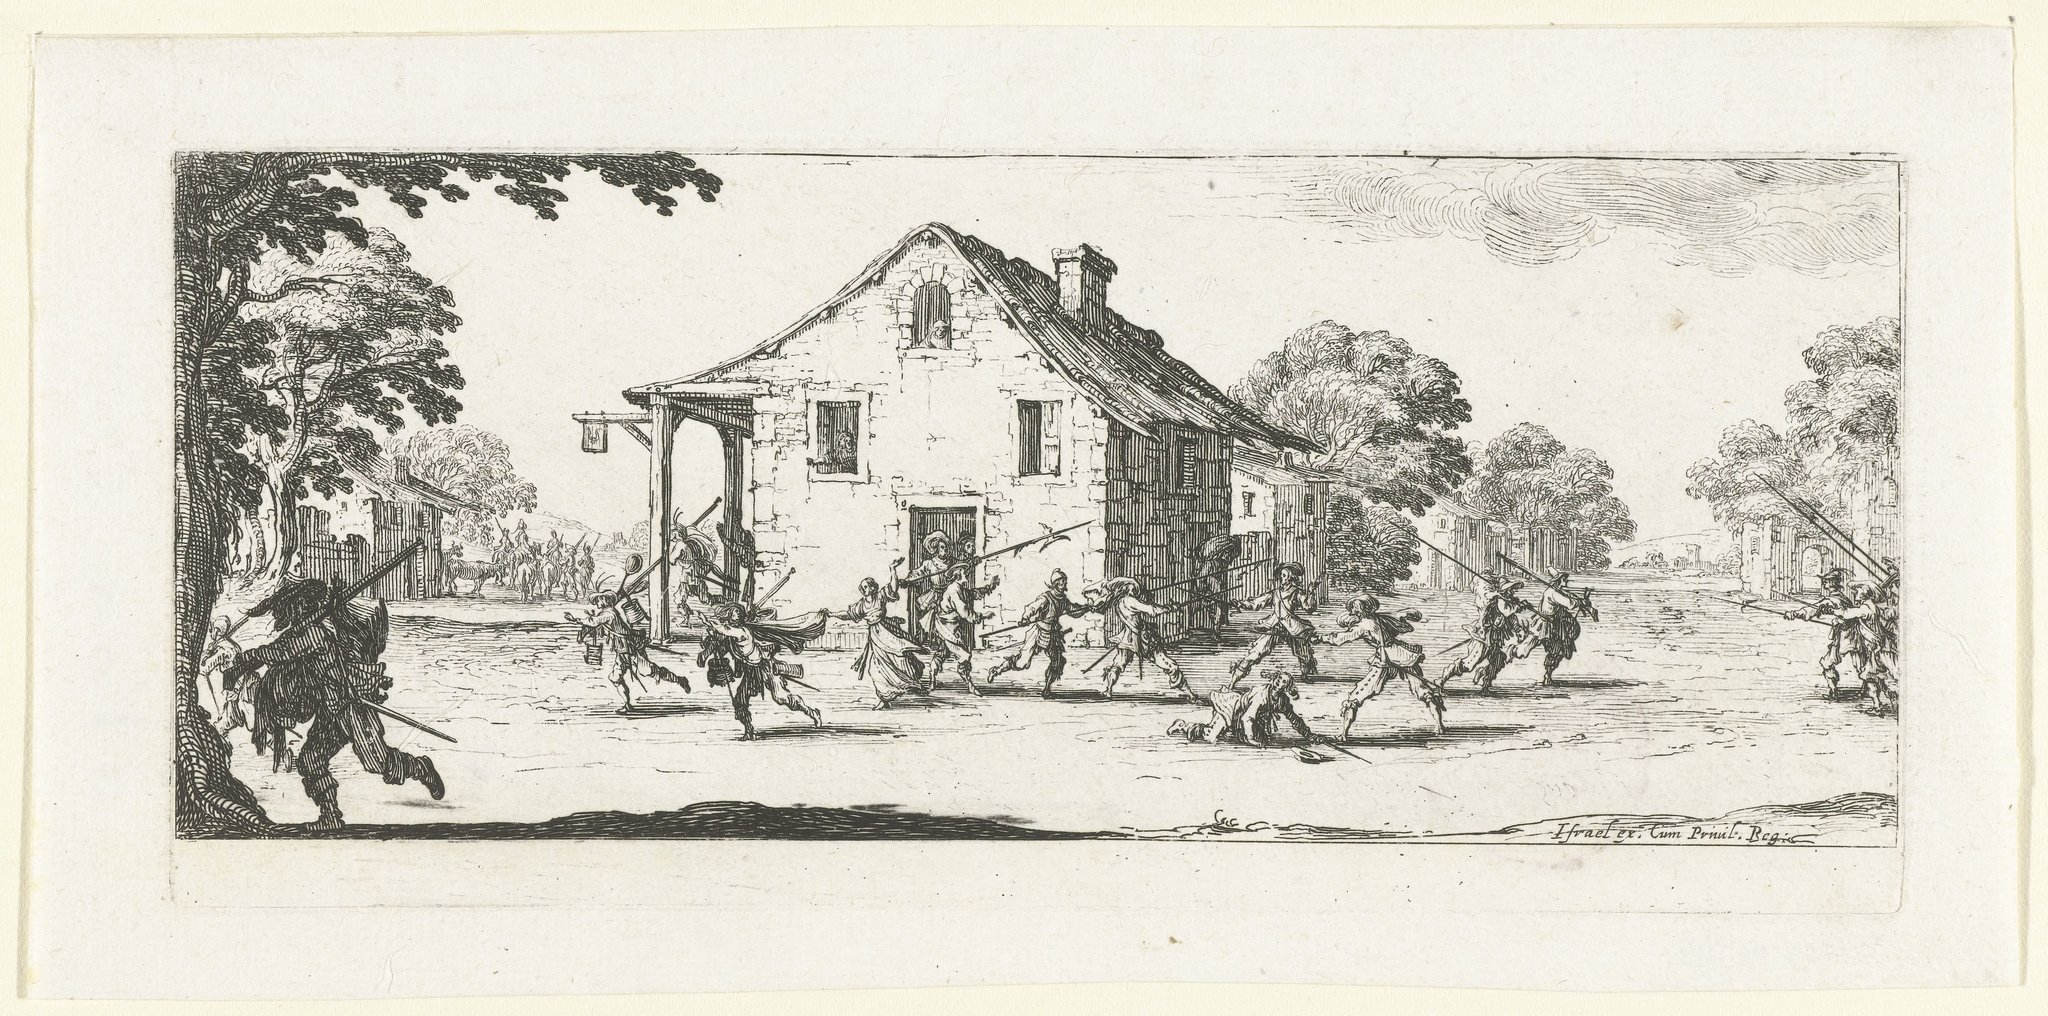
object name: print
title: De gruwelen van de oorlog (groot)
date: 1633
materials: paper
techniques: etching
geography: nancy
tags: plundering ~ soldiers, soldiers and civilians, hotel, hostelry, inn, fighting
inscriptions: collector's mark: Lugt 240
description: Soldaten verlaten al vechtend een herberg die ze zojuist geplunderd hebben. Onder de voorstelling een lege marge. Deze prent is onderdeel van een serie van 17 (18 incl. titelprent) prenten met voorstellingen van diverse soorten ellende die oorlogvoering met zich meebrengt.